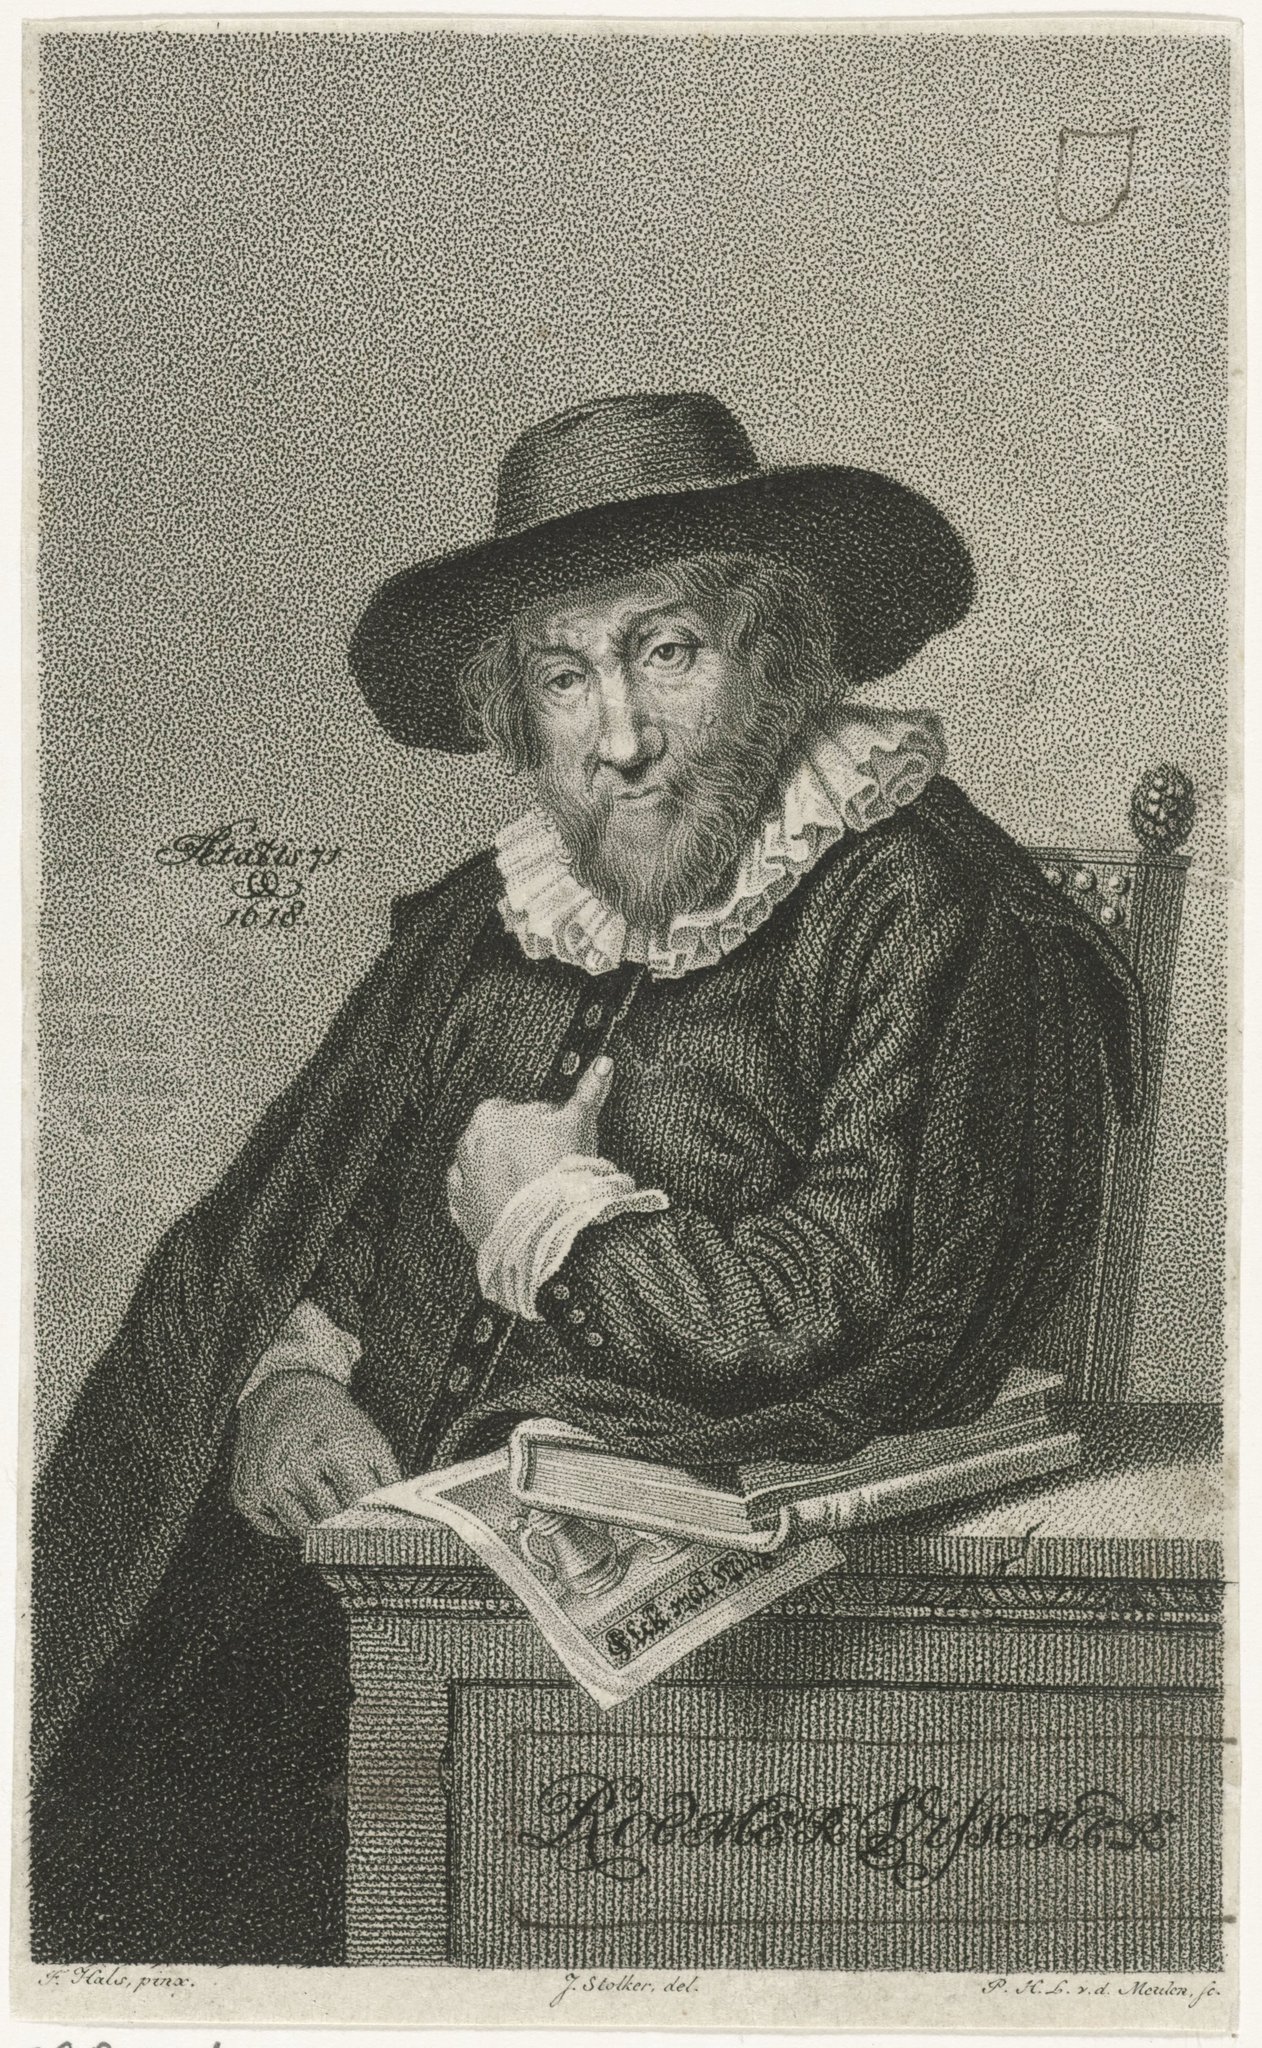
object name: print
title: Portret van Roemer Visscher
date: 1790-1858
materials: paper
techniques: stippled etching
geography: amsterdam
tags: amsterdam, roemer visscher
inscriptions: collector's mark: Lugt 2228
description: Portret van koopman en dichter Roemer Visscher op 71-jarige leeftijd, zittend bij een tafel.